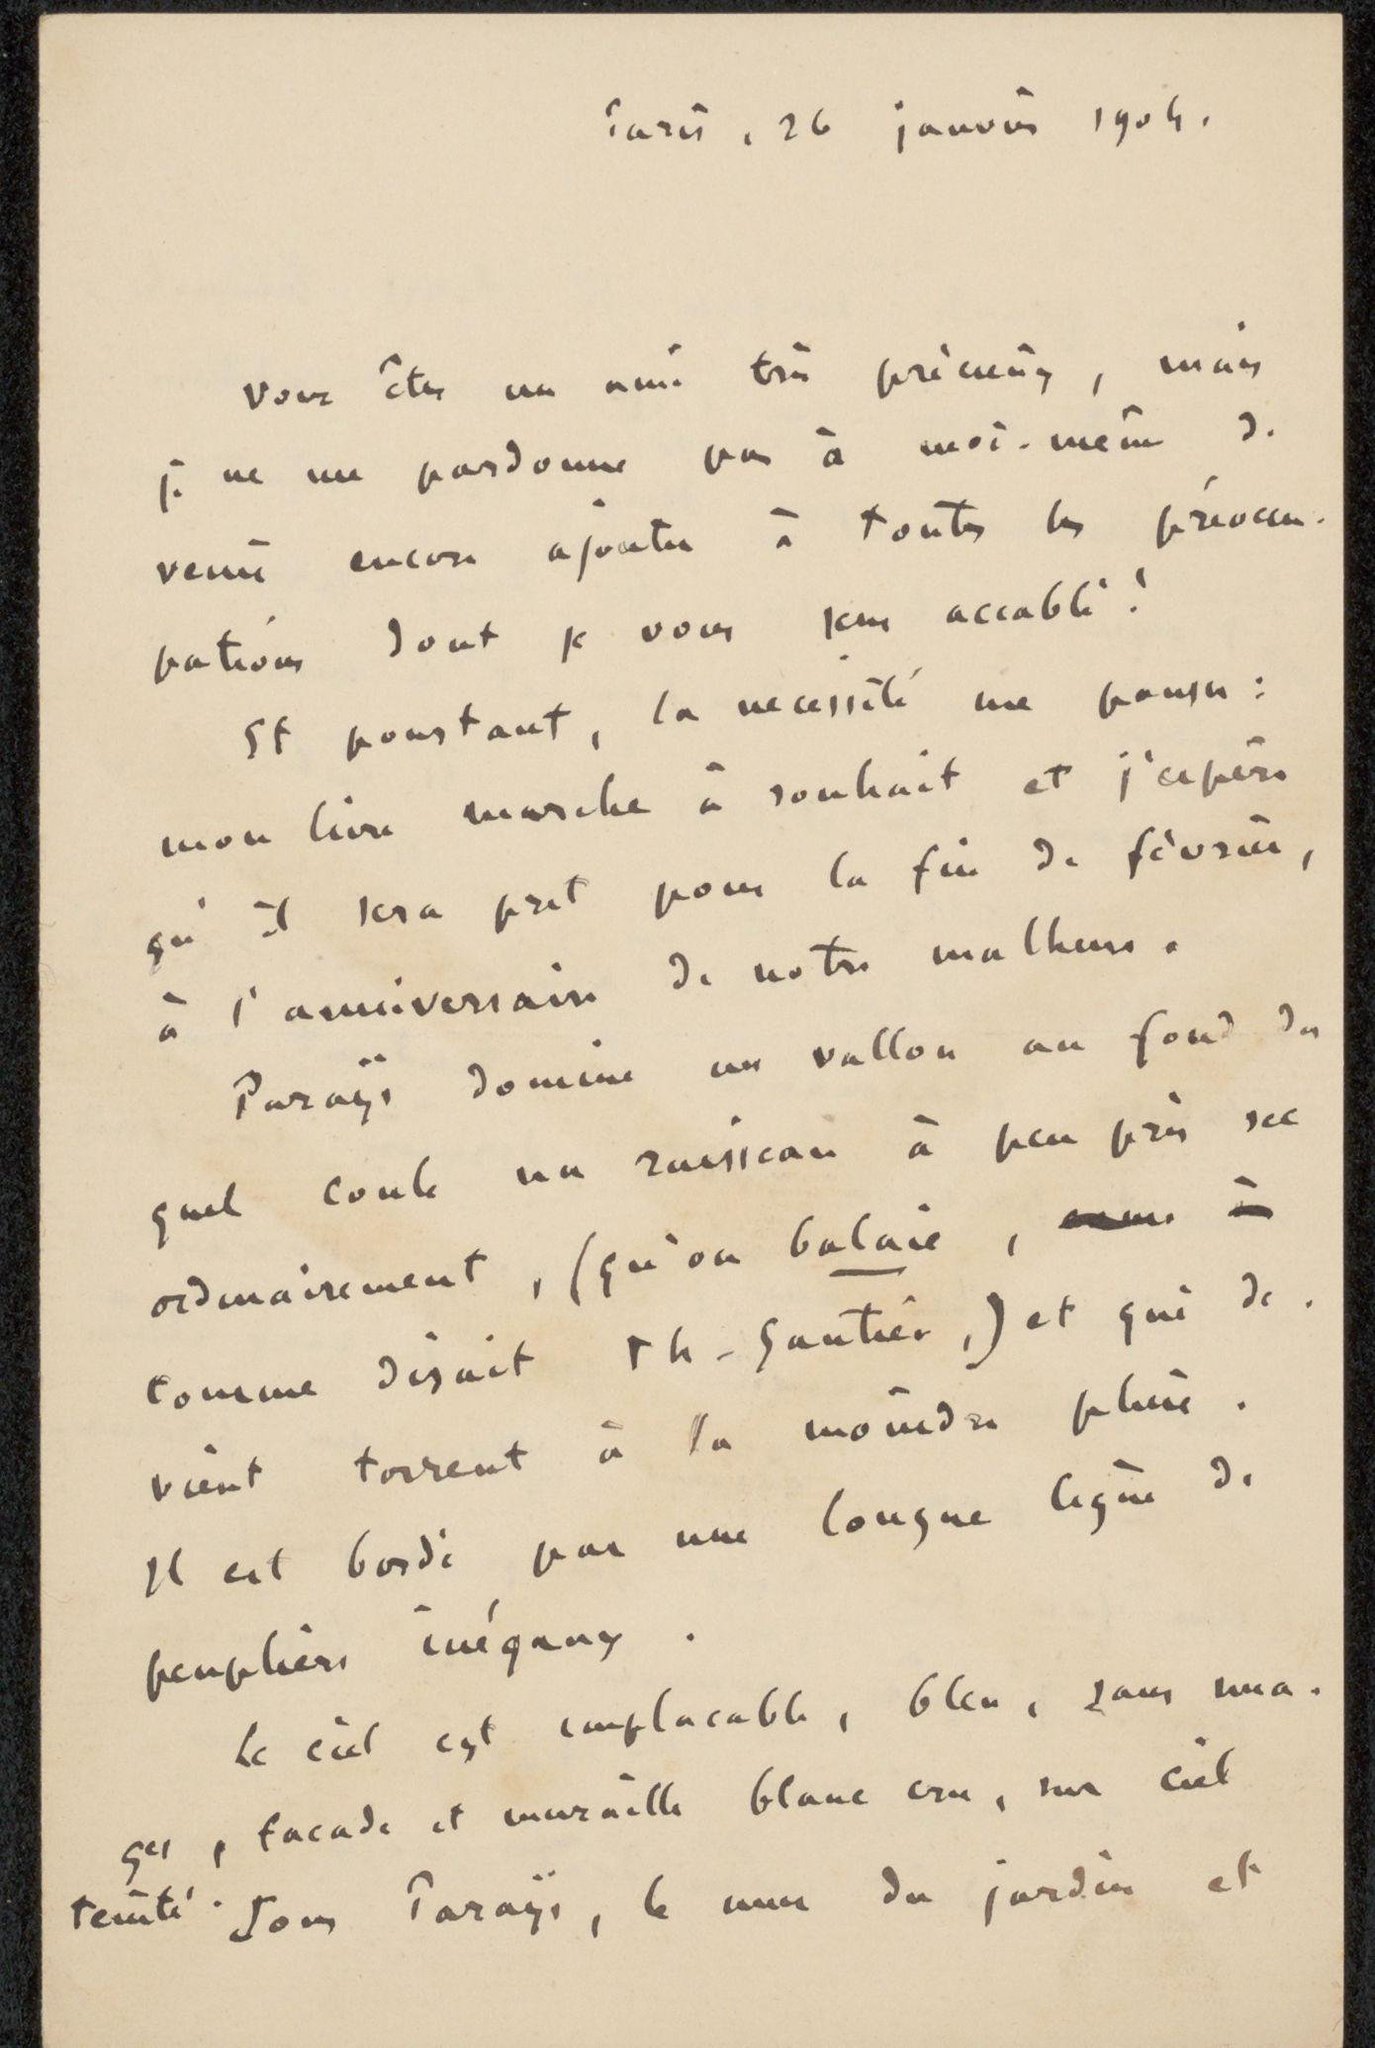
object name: letter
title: Brief aan Philip Zilcken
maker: alidor delzant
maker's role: advocaat, auteur, kunstverzamelaar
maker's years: 1848-1905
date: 1904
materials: ink, paper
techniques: pen, writing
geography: paris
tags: paris, print maker, félix bracquemond, the hague, painter, draughtsman, philip zilcken, the graphic arts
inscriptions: collector's mark: ‘RPK’, watermark